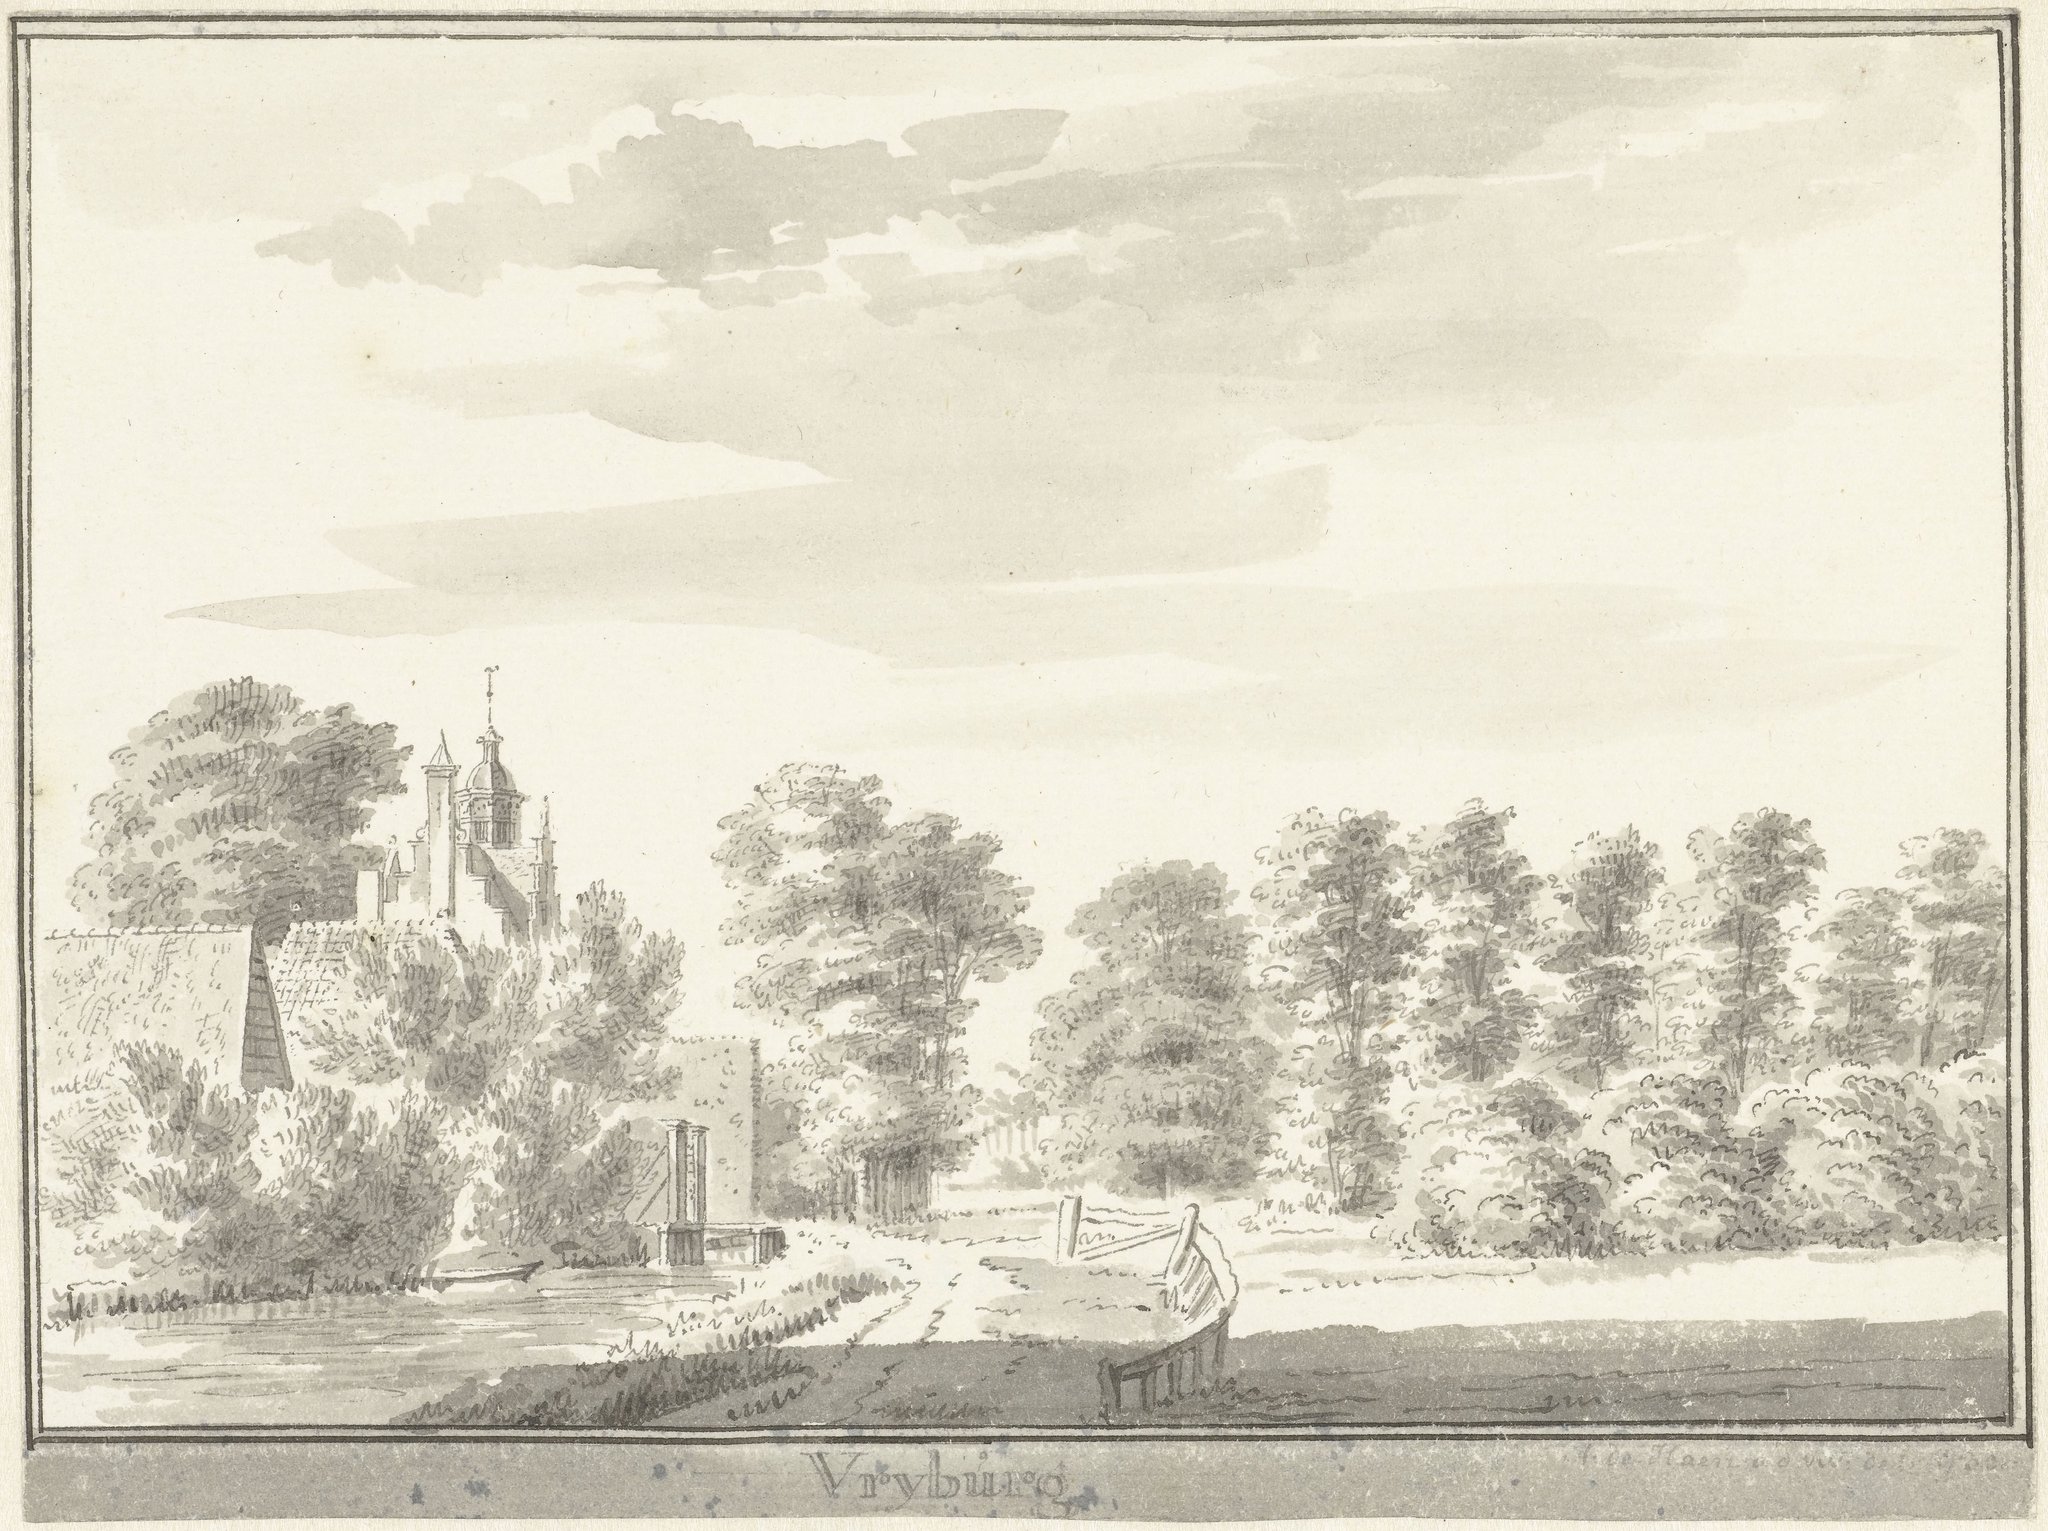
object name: drawing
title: Het huis Vrijburg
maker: abraham de haen (ii)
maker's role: draughtsman, print maker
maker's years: 1707-1748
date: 1730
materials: ink, paper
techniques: brush, pen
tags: castle